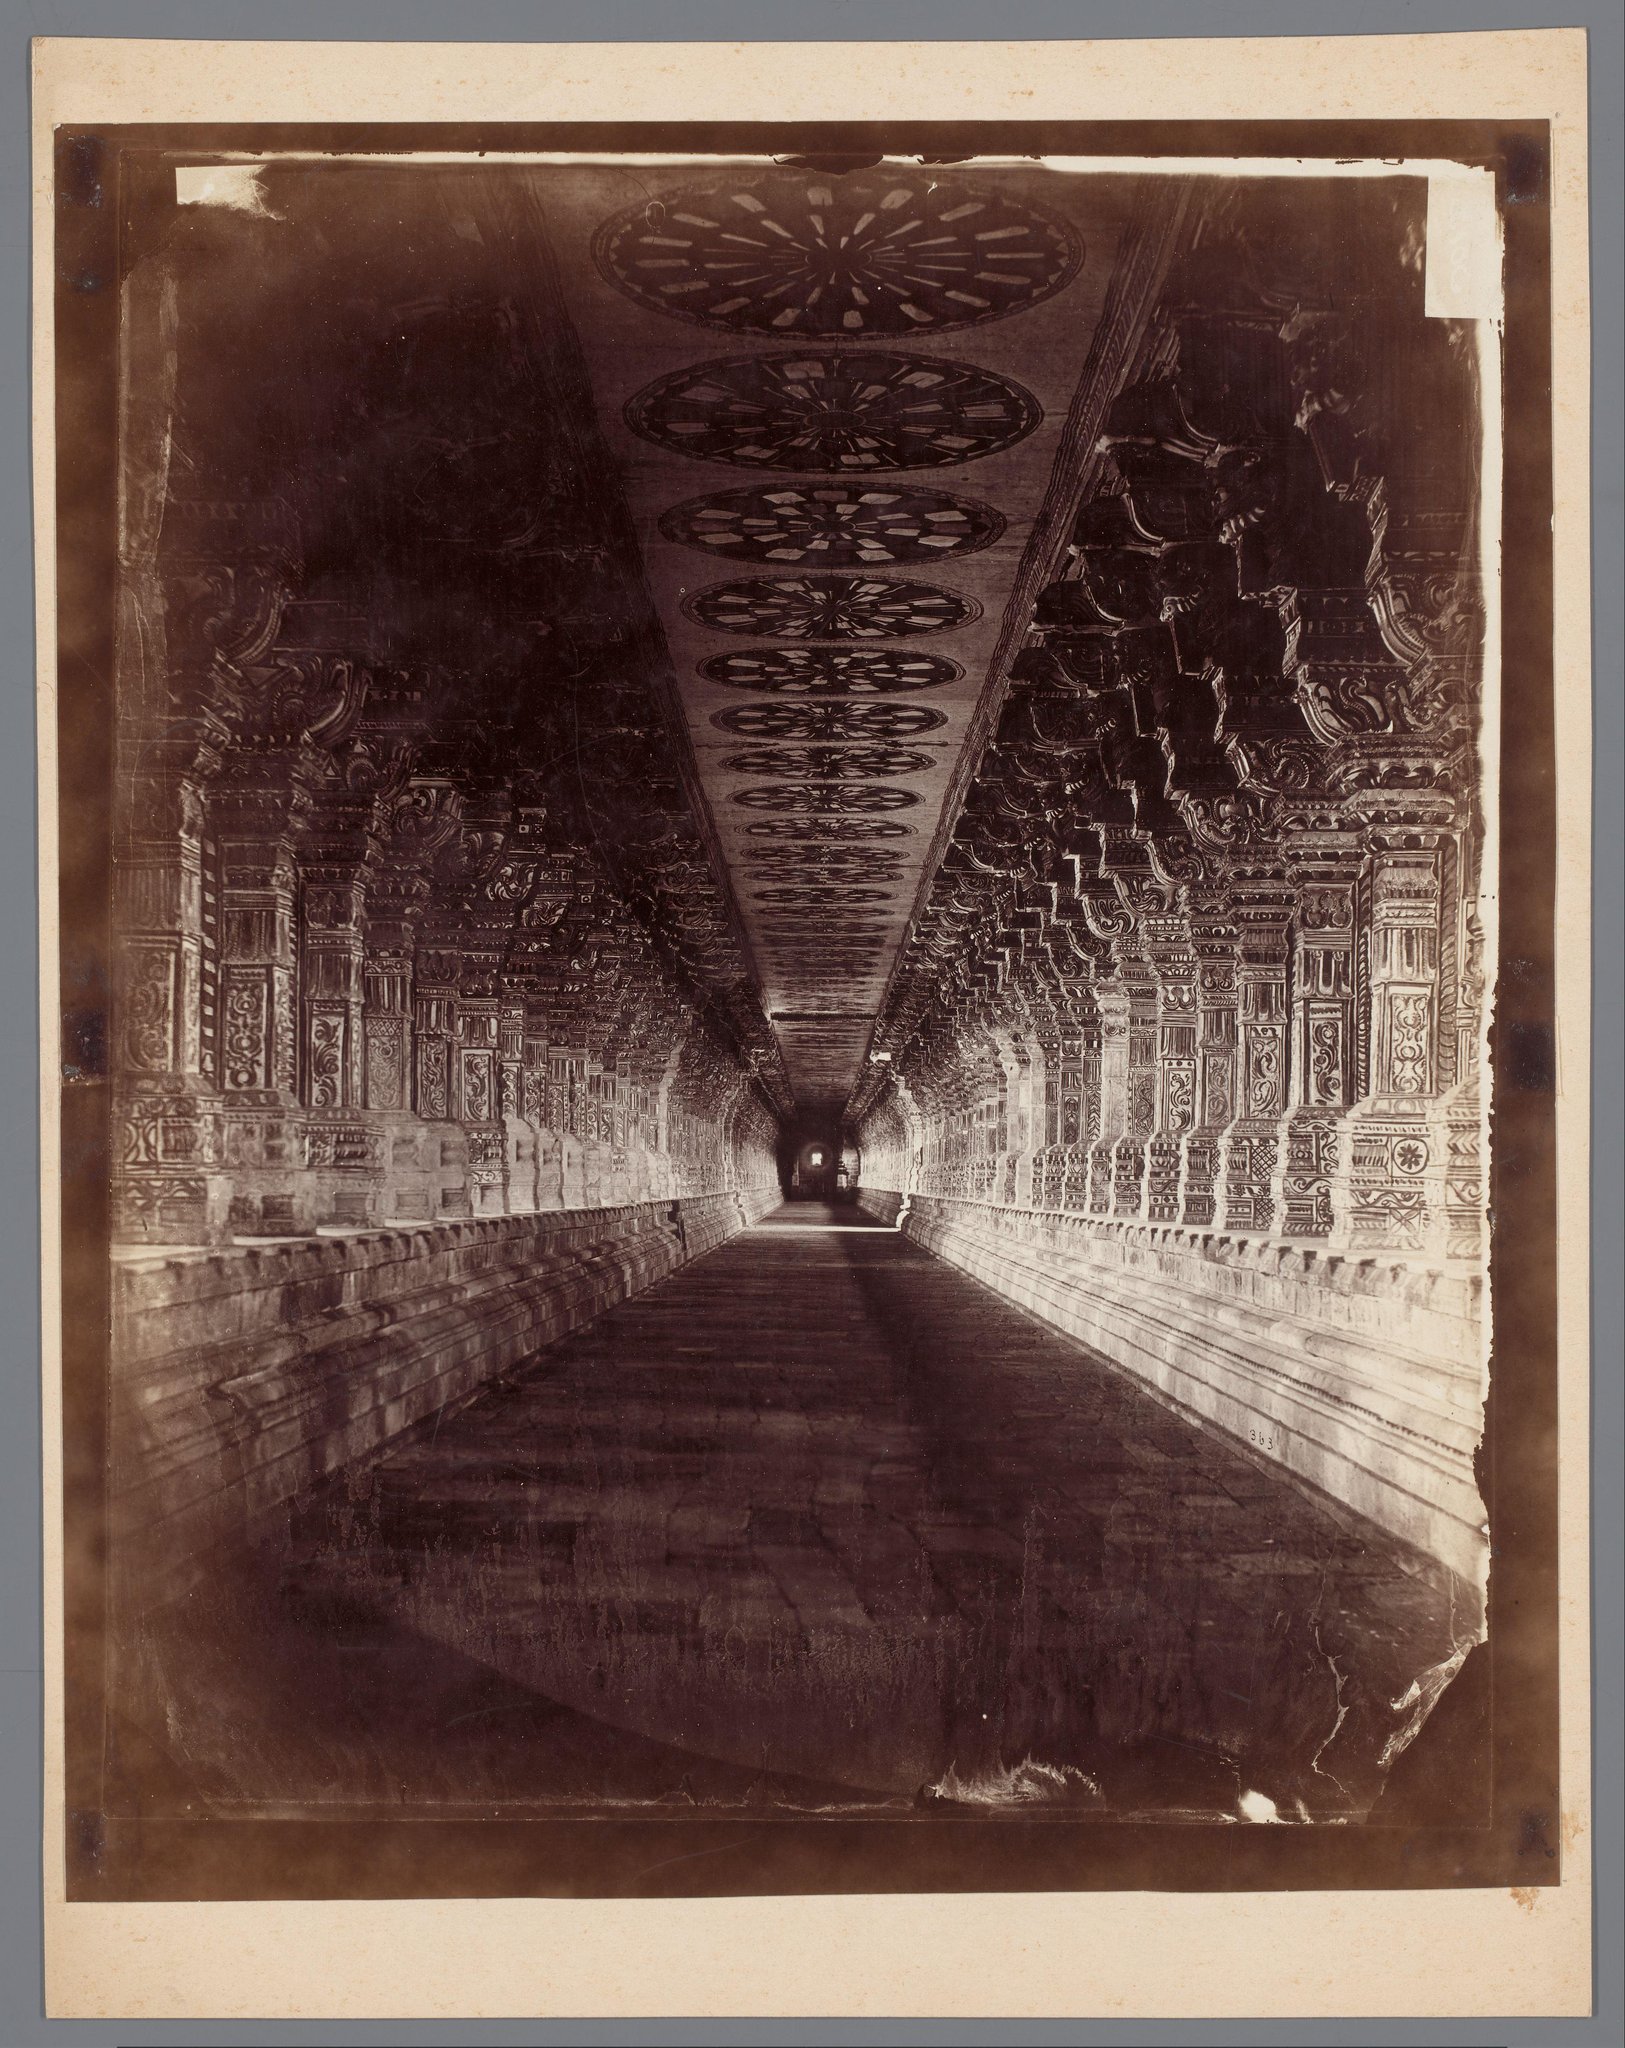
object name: photograph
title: Colonnade in the Ramanathaswamy temple in Rameswaram, Tamil Nadu, India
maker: Anonymous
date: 1870-1890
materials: paper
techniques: gelatin silver print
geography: rameswaram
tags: temple, shrine ~ hinduism, buddhism, jainism, corridor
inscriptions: title: ‘Ramiswaram/ Long aisle’, number: ‘363’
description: Deze zuilengang behoort tot de langste tempelgangen in India. Hij maakt deel uit van de hindoeïstische Ramanathaswamy-tempel in Rameswaram, in de deelstaat Tamil Nadu. De tempel is een van de twaalf Jyotirlinga Shiva-tempels. Volgens de Ramayana bad Rama hier tot de god Shiva voor zegen van Ravana, de koning van Lanka. De tempel is beroemd om de lange gangen, die de langste ter wereld zijn.